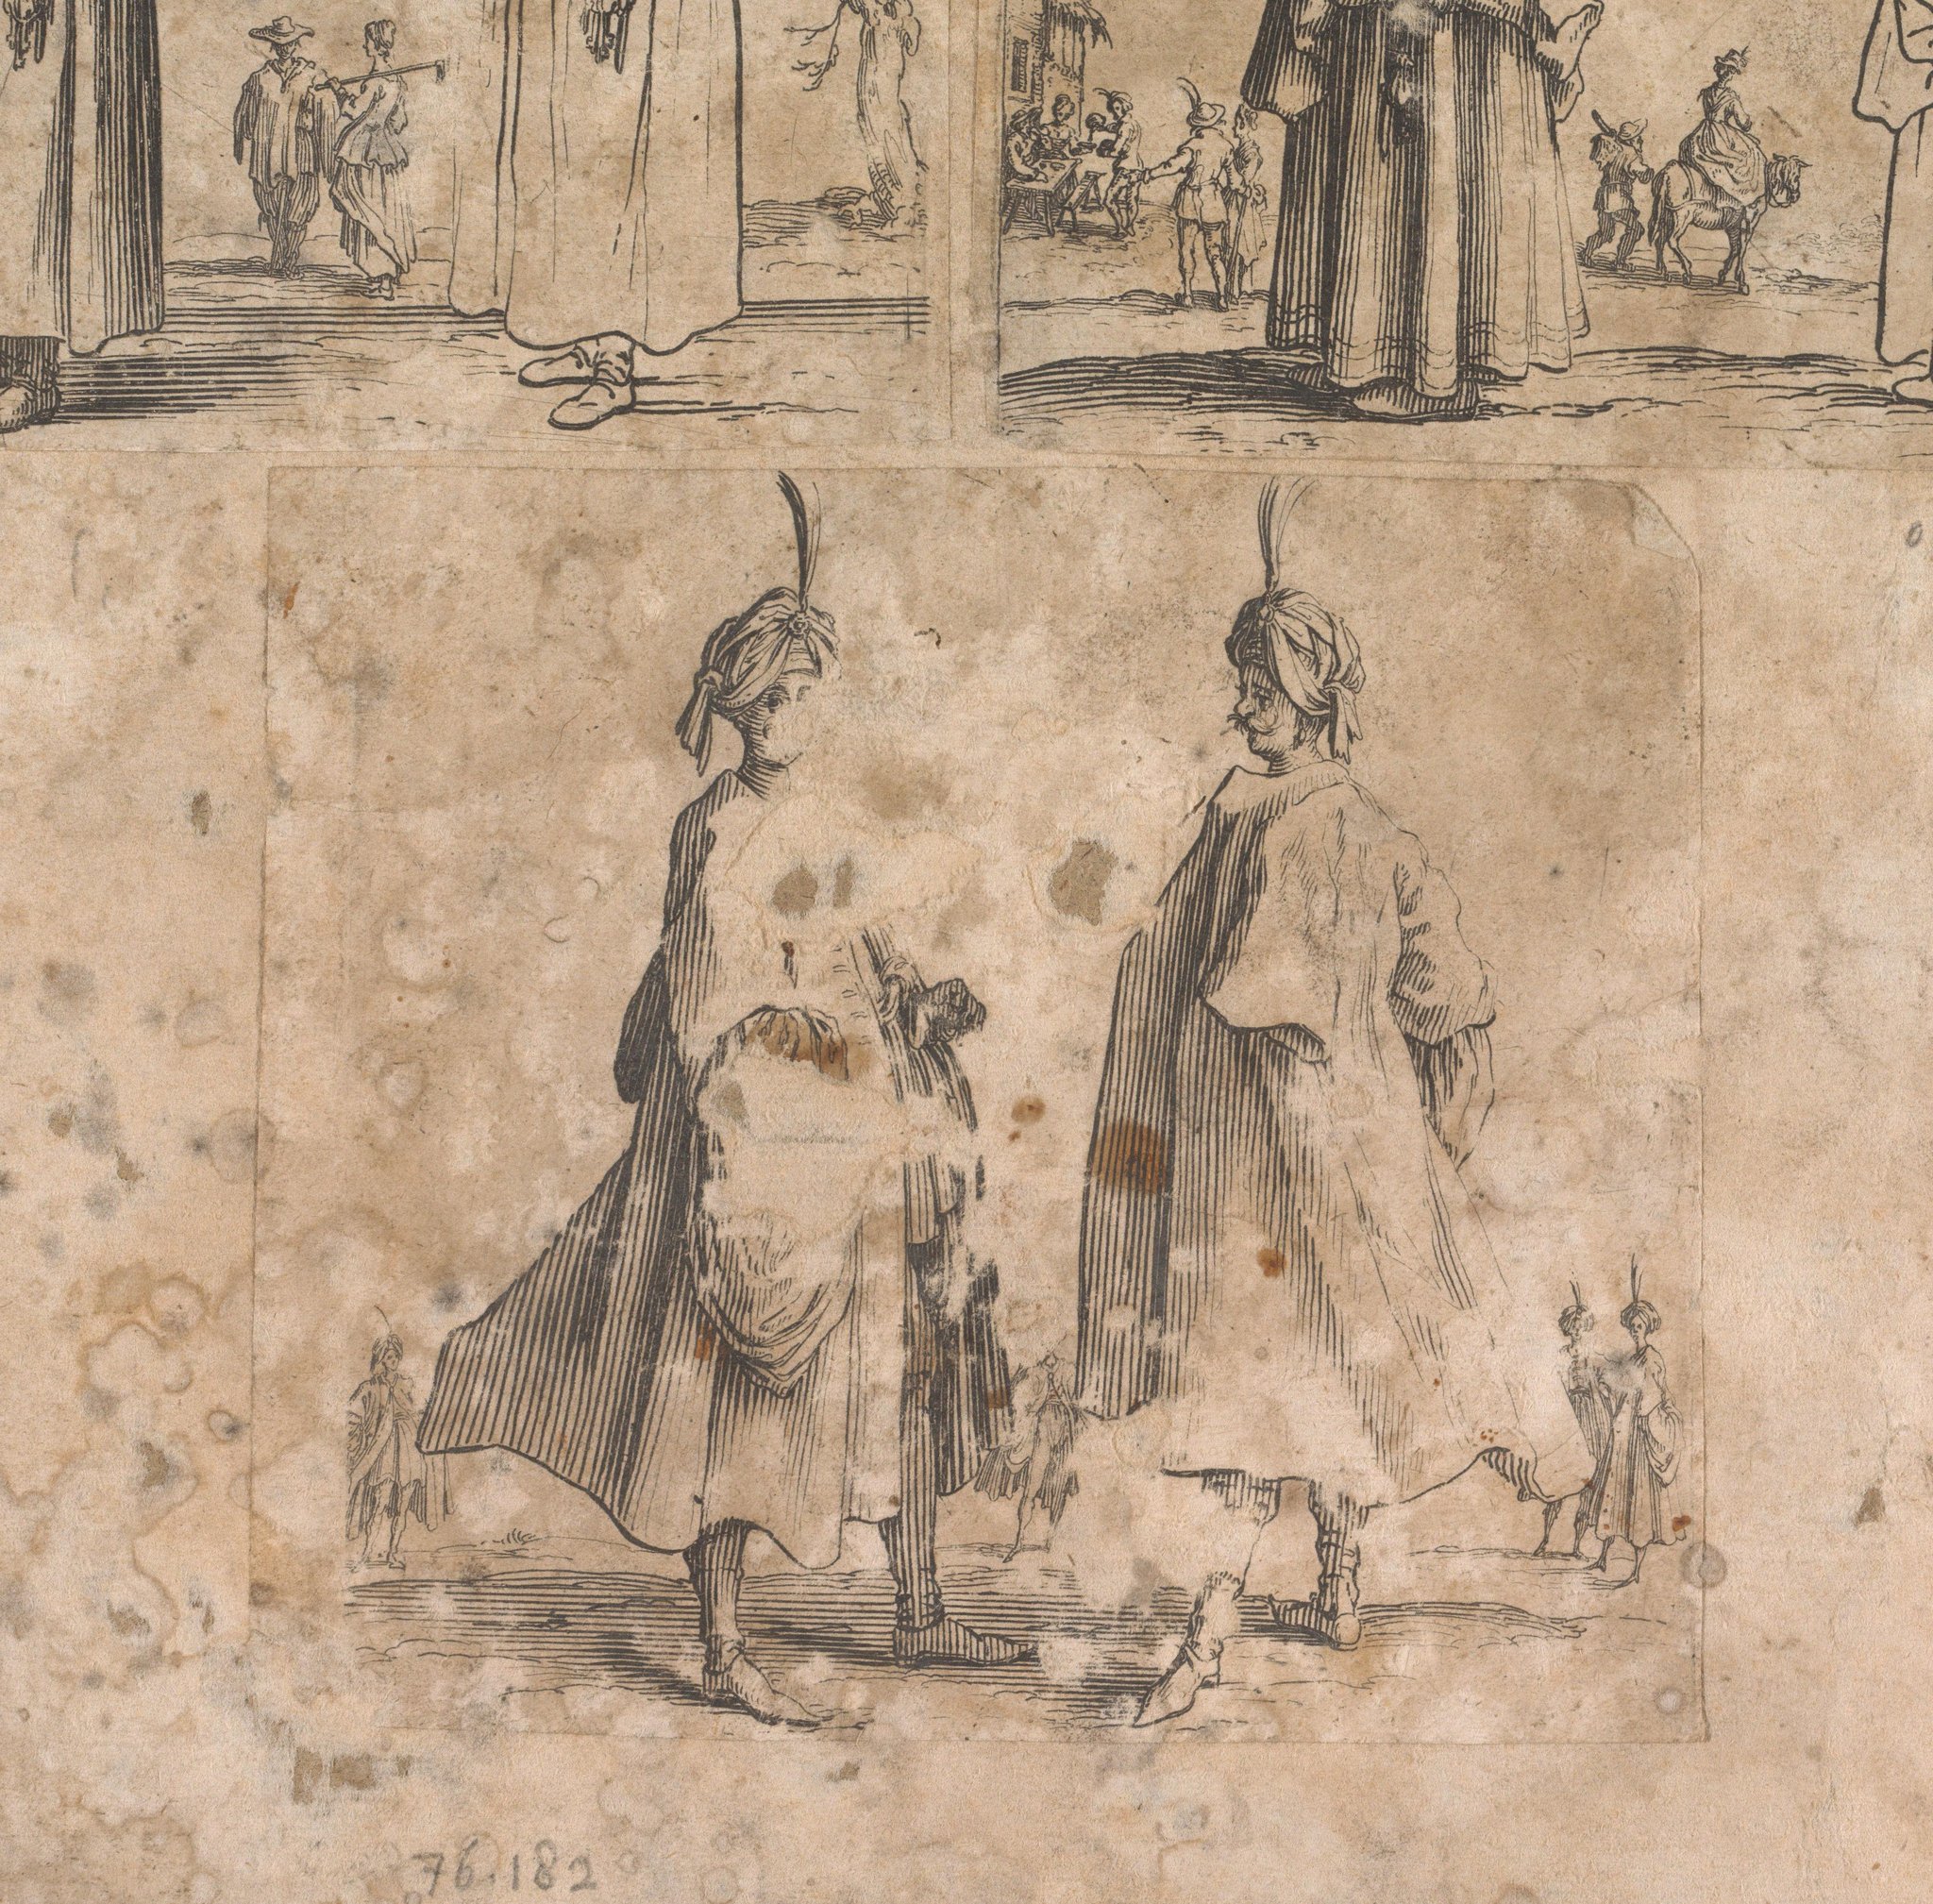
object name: print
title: Twee mannen in mantel met tulband op het hoofd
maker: Anonymous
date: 1650-1750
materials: paper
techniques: etching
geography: low countries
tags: head-gear: turban, folk costume, regional costume